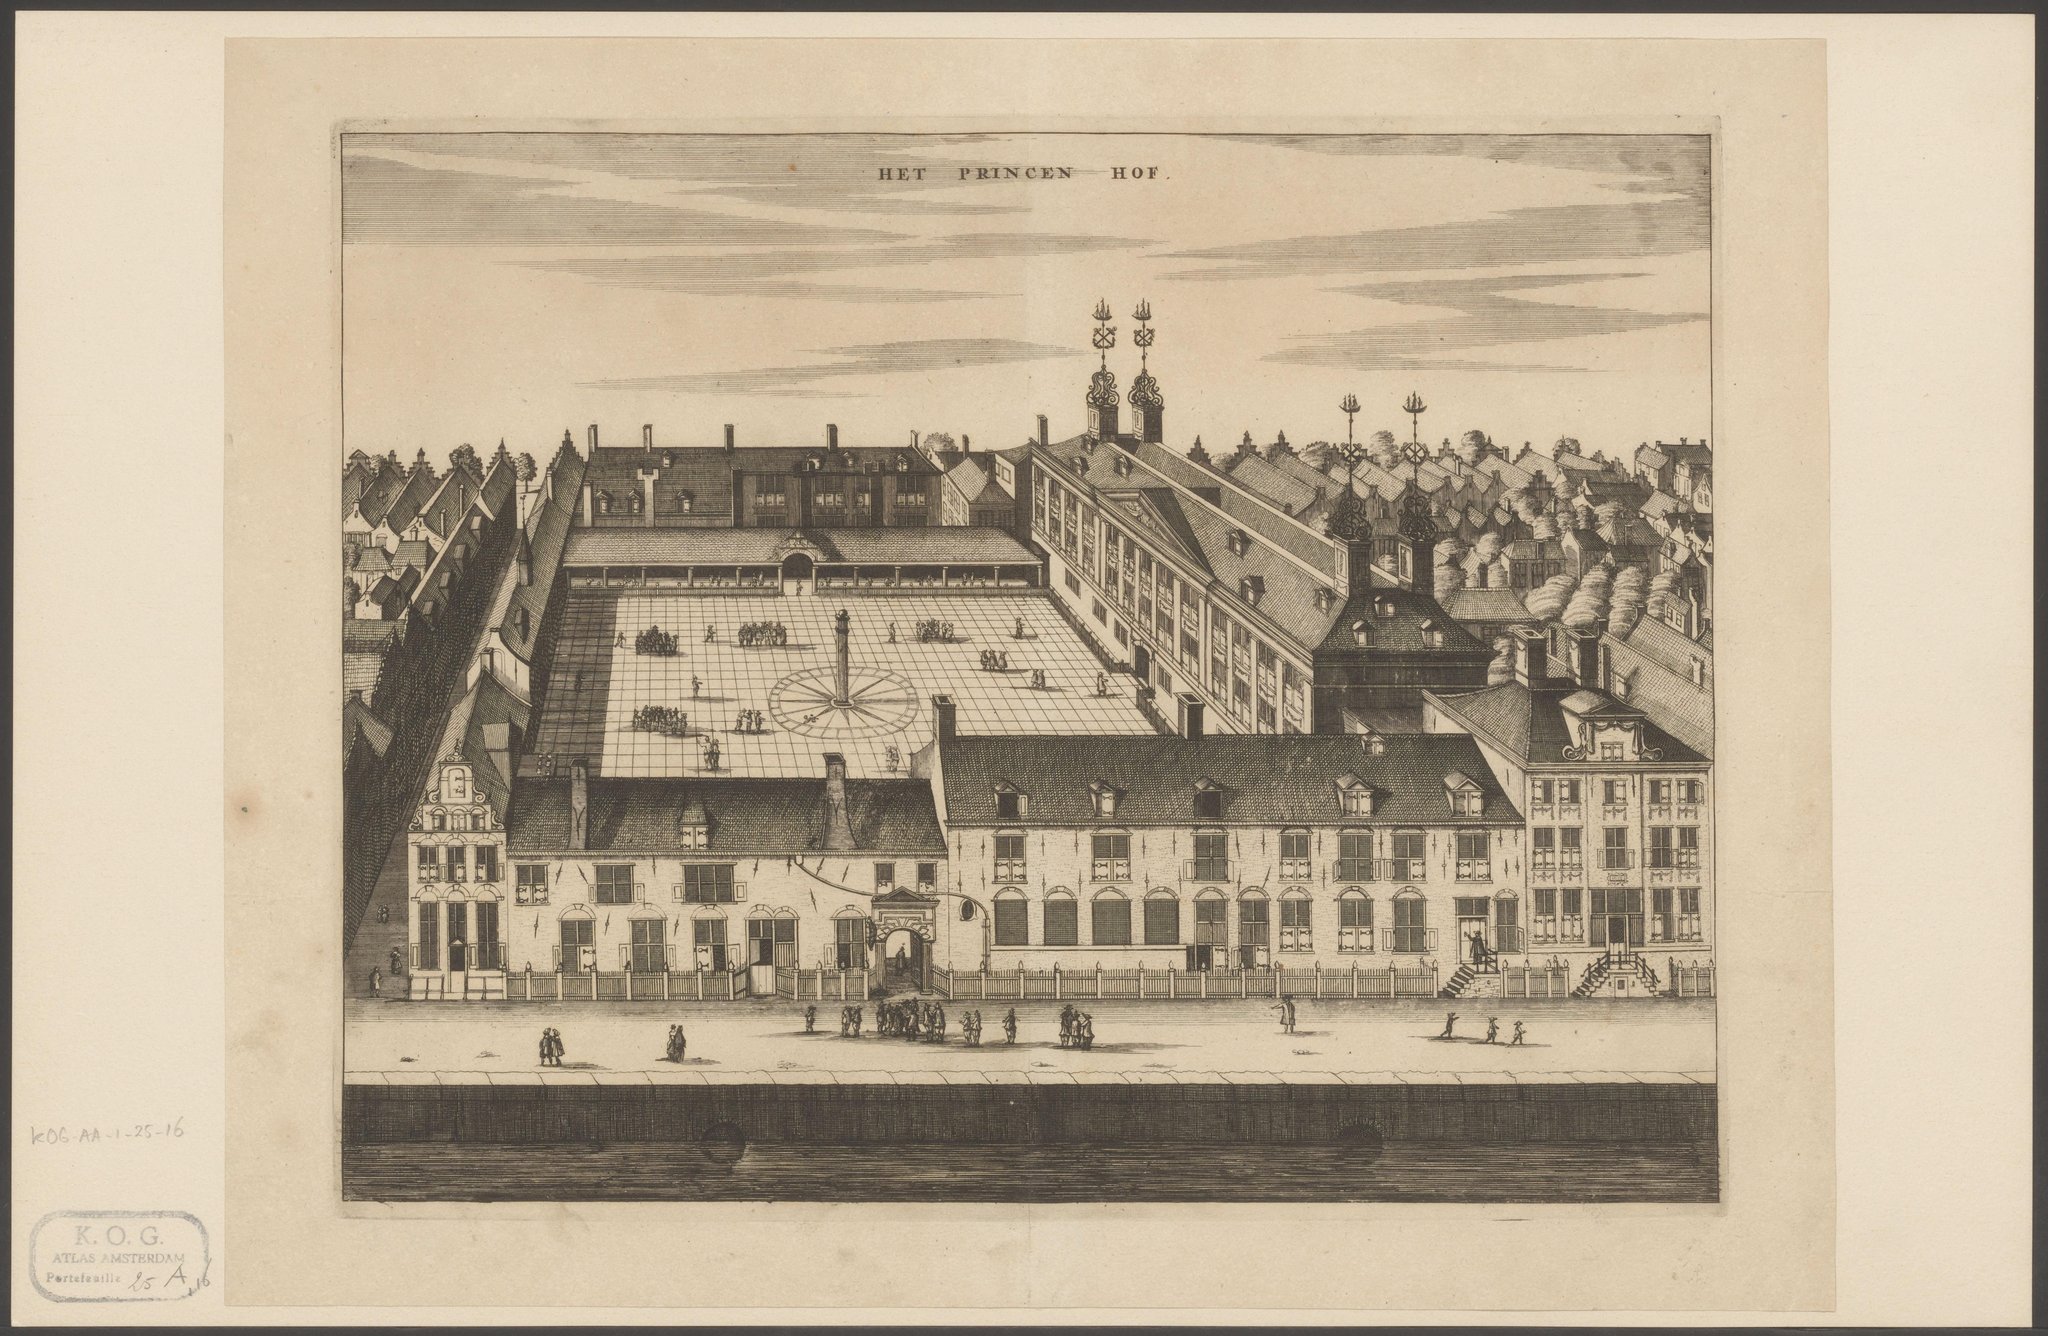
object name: book illustration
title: Gezicht op het Prinsenhof te Amsterdam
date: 1693-1694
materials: paper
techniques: engraving, etching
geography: amsterdam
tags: canals, waters (in city), bird's eye view ~ representation of building, courtyard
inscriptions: collector's mark: ‘25A.16’ Lugt 1641b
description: Huidige staat van prent ook gebruikt in: Commelin, Caspar. Beschryvinge van Amsterdam, desselfs eerste oorspronk uyt den Huyse (…). 2 dln. Amsterdam: Abraham Wolfgang, Gillis Janssonius van Waesberge, Johannes Janssonius van Waesberge II, weduwe Dirk Boom I, Hendrick Boom en Rembertus Goethals, 1693. En in: Commelin, Caspar. Beschryvinge van Amsterdam, zynde een naukeurige verhandelinge van desselfs eerste oorspronk uyt (…). 2 dln. Amsterdam: weduwe Aart Dircksz Oossaan, 1694. Latere staat ook gebruikt in: Commelin, Caspar. Beschryvinge van Amsterdam, zynde een naukeurige verhandelinge van desselfs eerste oorspronk uyt (…). 2 dln. 2de druk. Amsterdam: Andries van Damme, Johannes Ratelband, weduwe A. van Aaltwyk en Hermanus Uytwerf, 1726.